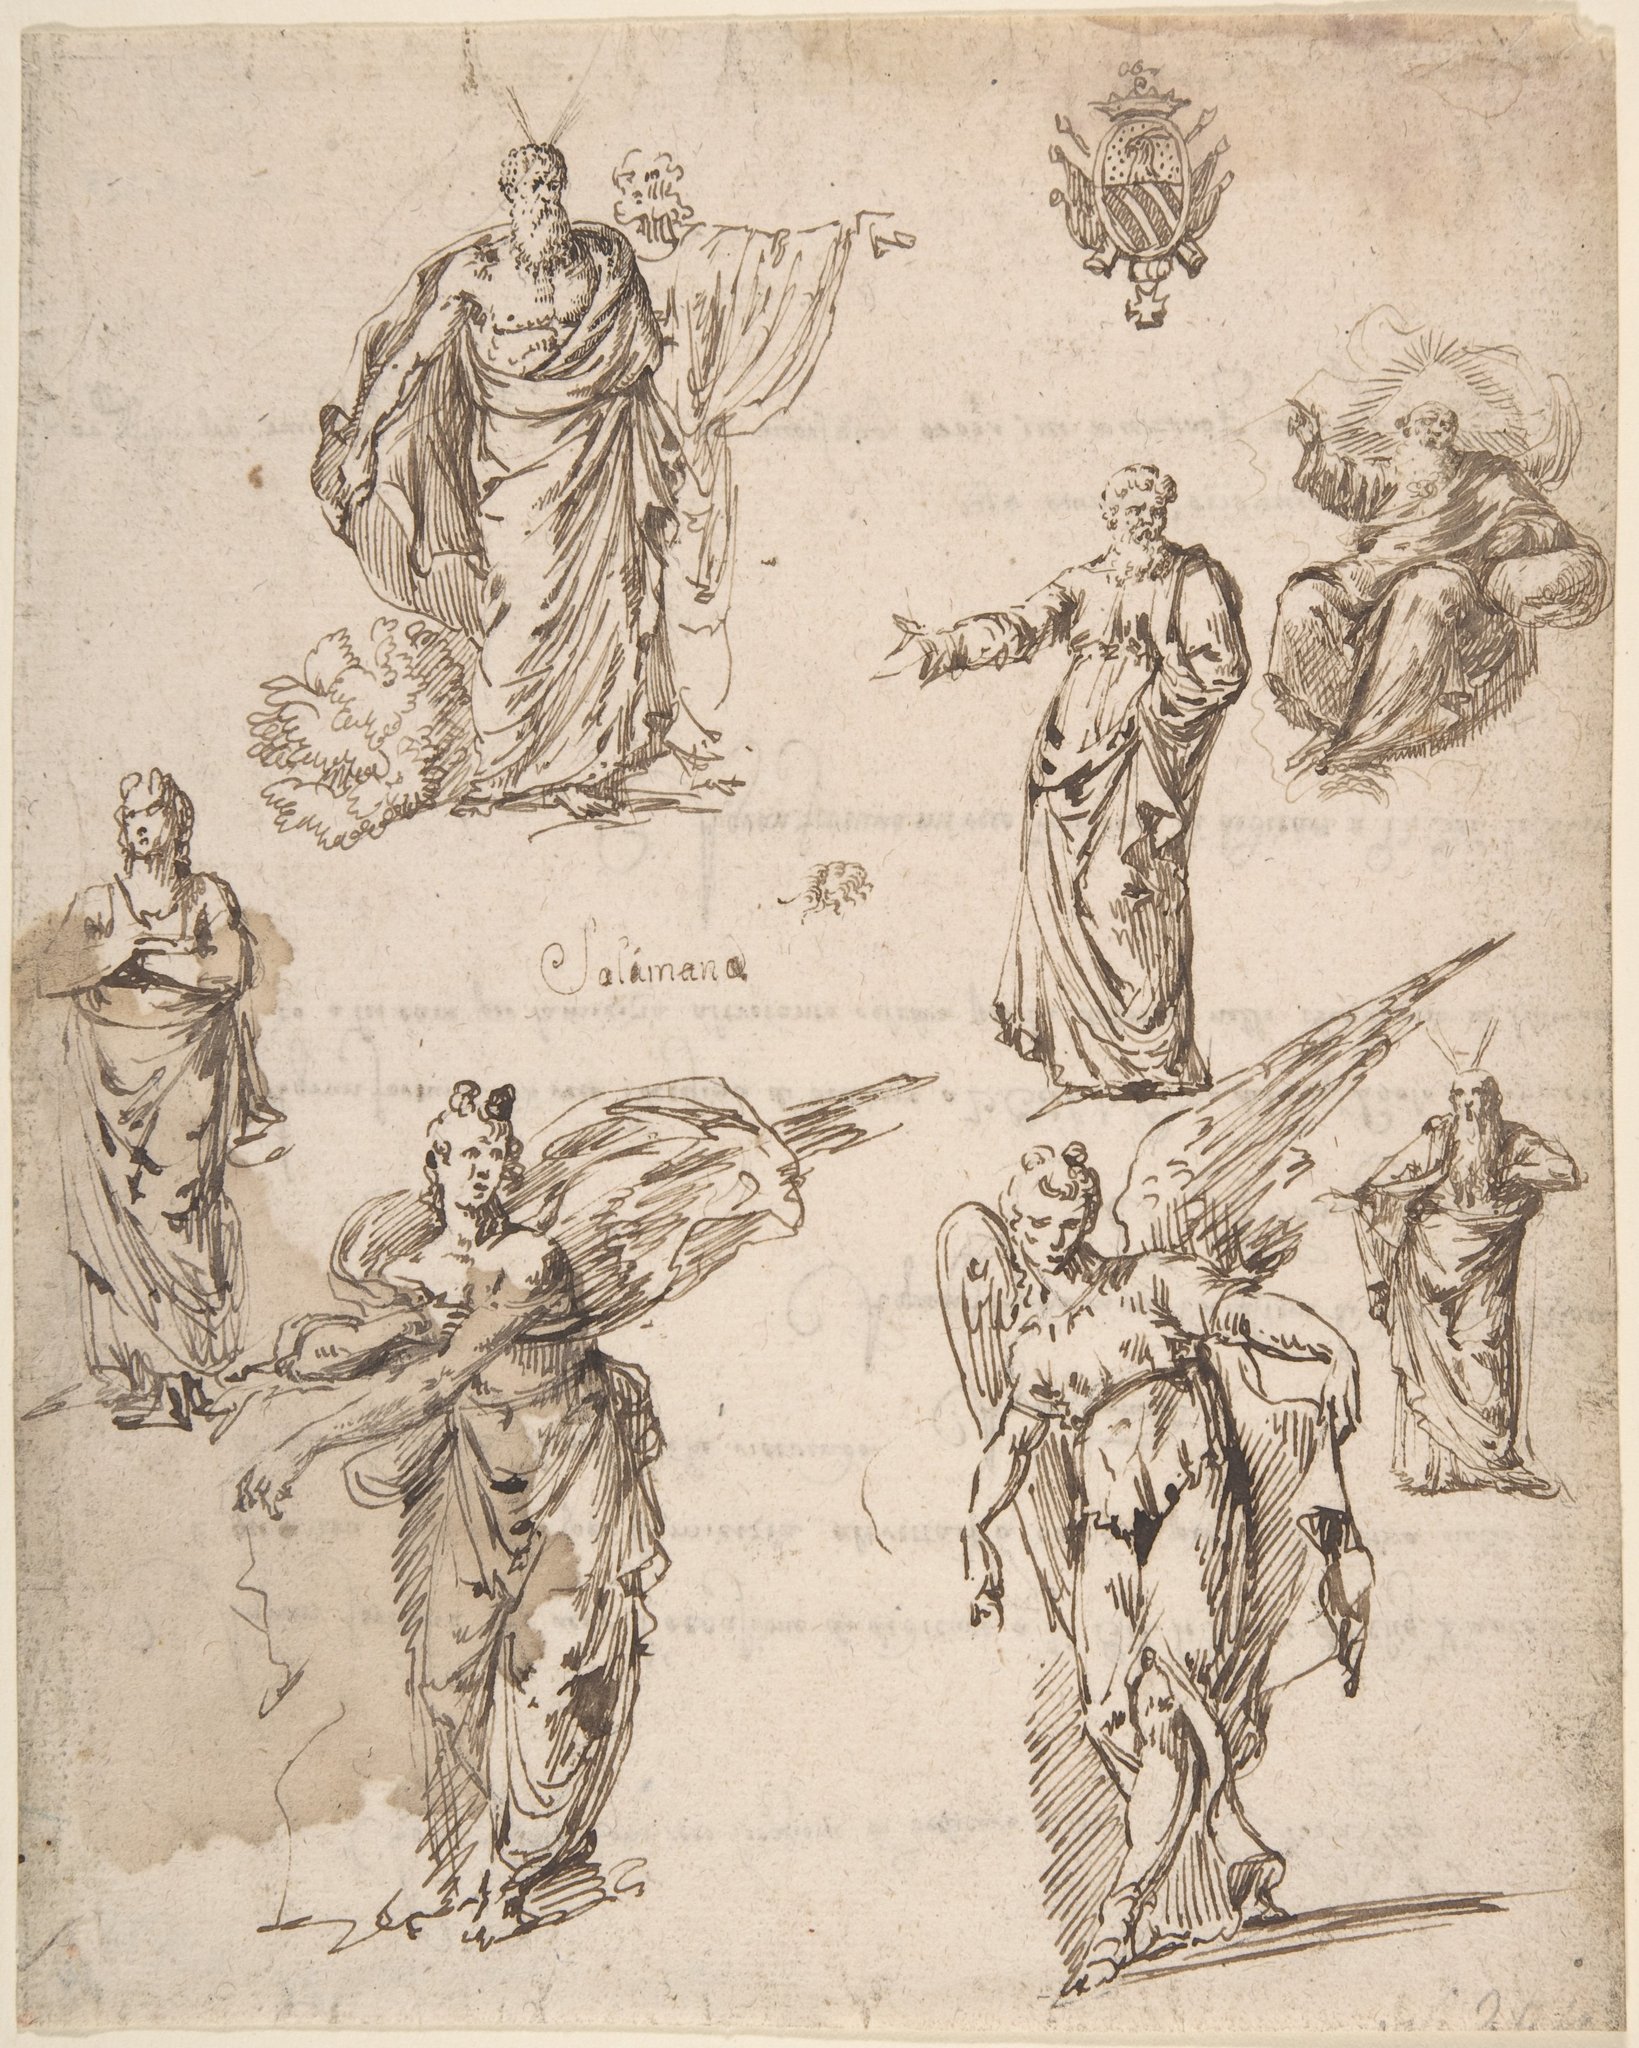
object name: drawing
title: Sheet of Studies with Angels and Religious Figures (recto); Draft of a Letter (verso)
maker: anonymous, italian, 17th century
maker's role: artist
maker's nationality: italian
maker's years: 1600-1700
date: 1601-1700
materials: graphite, ink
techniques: pen, drawing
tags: men,angels,coat of arms